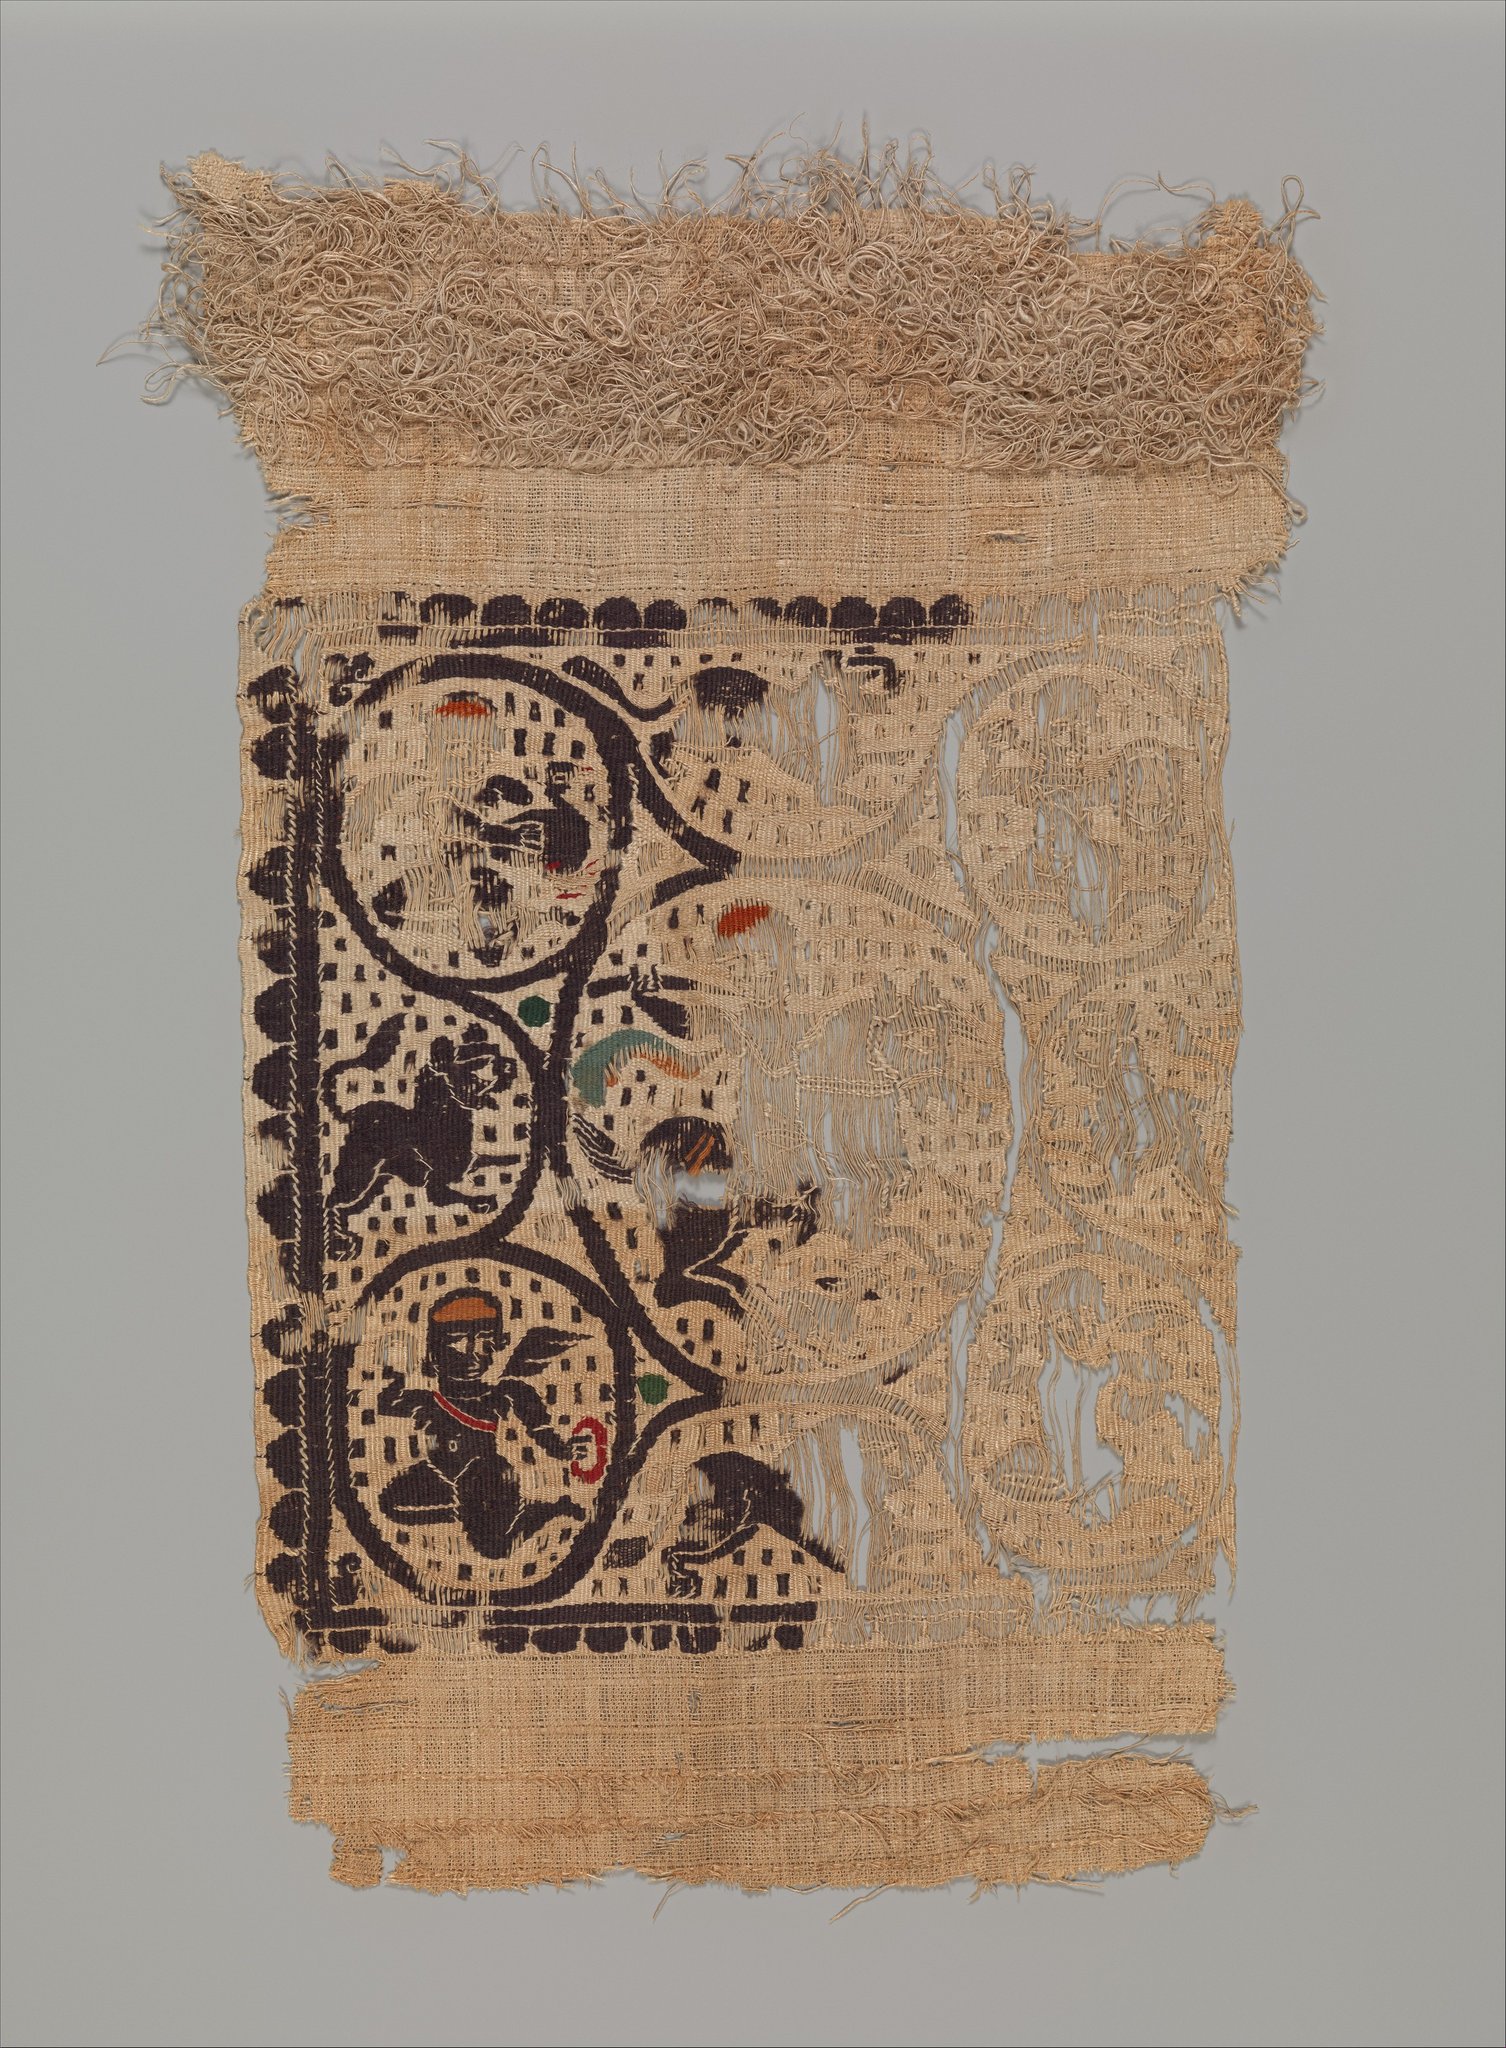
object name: textile fragment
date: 301-500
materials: linen, wool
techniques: embroidery, weave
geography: egypt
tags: animals,horses